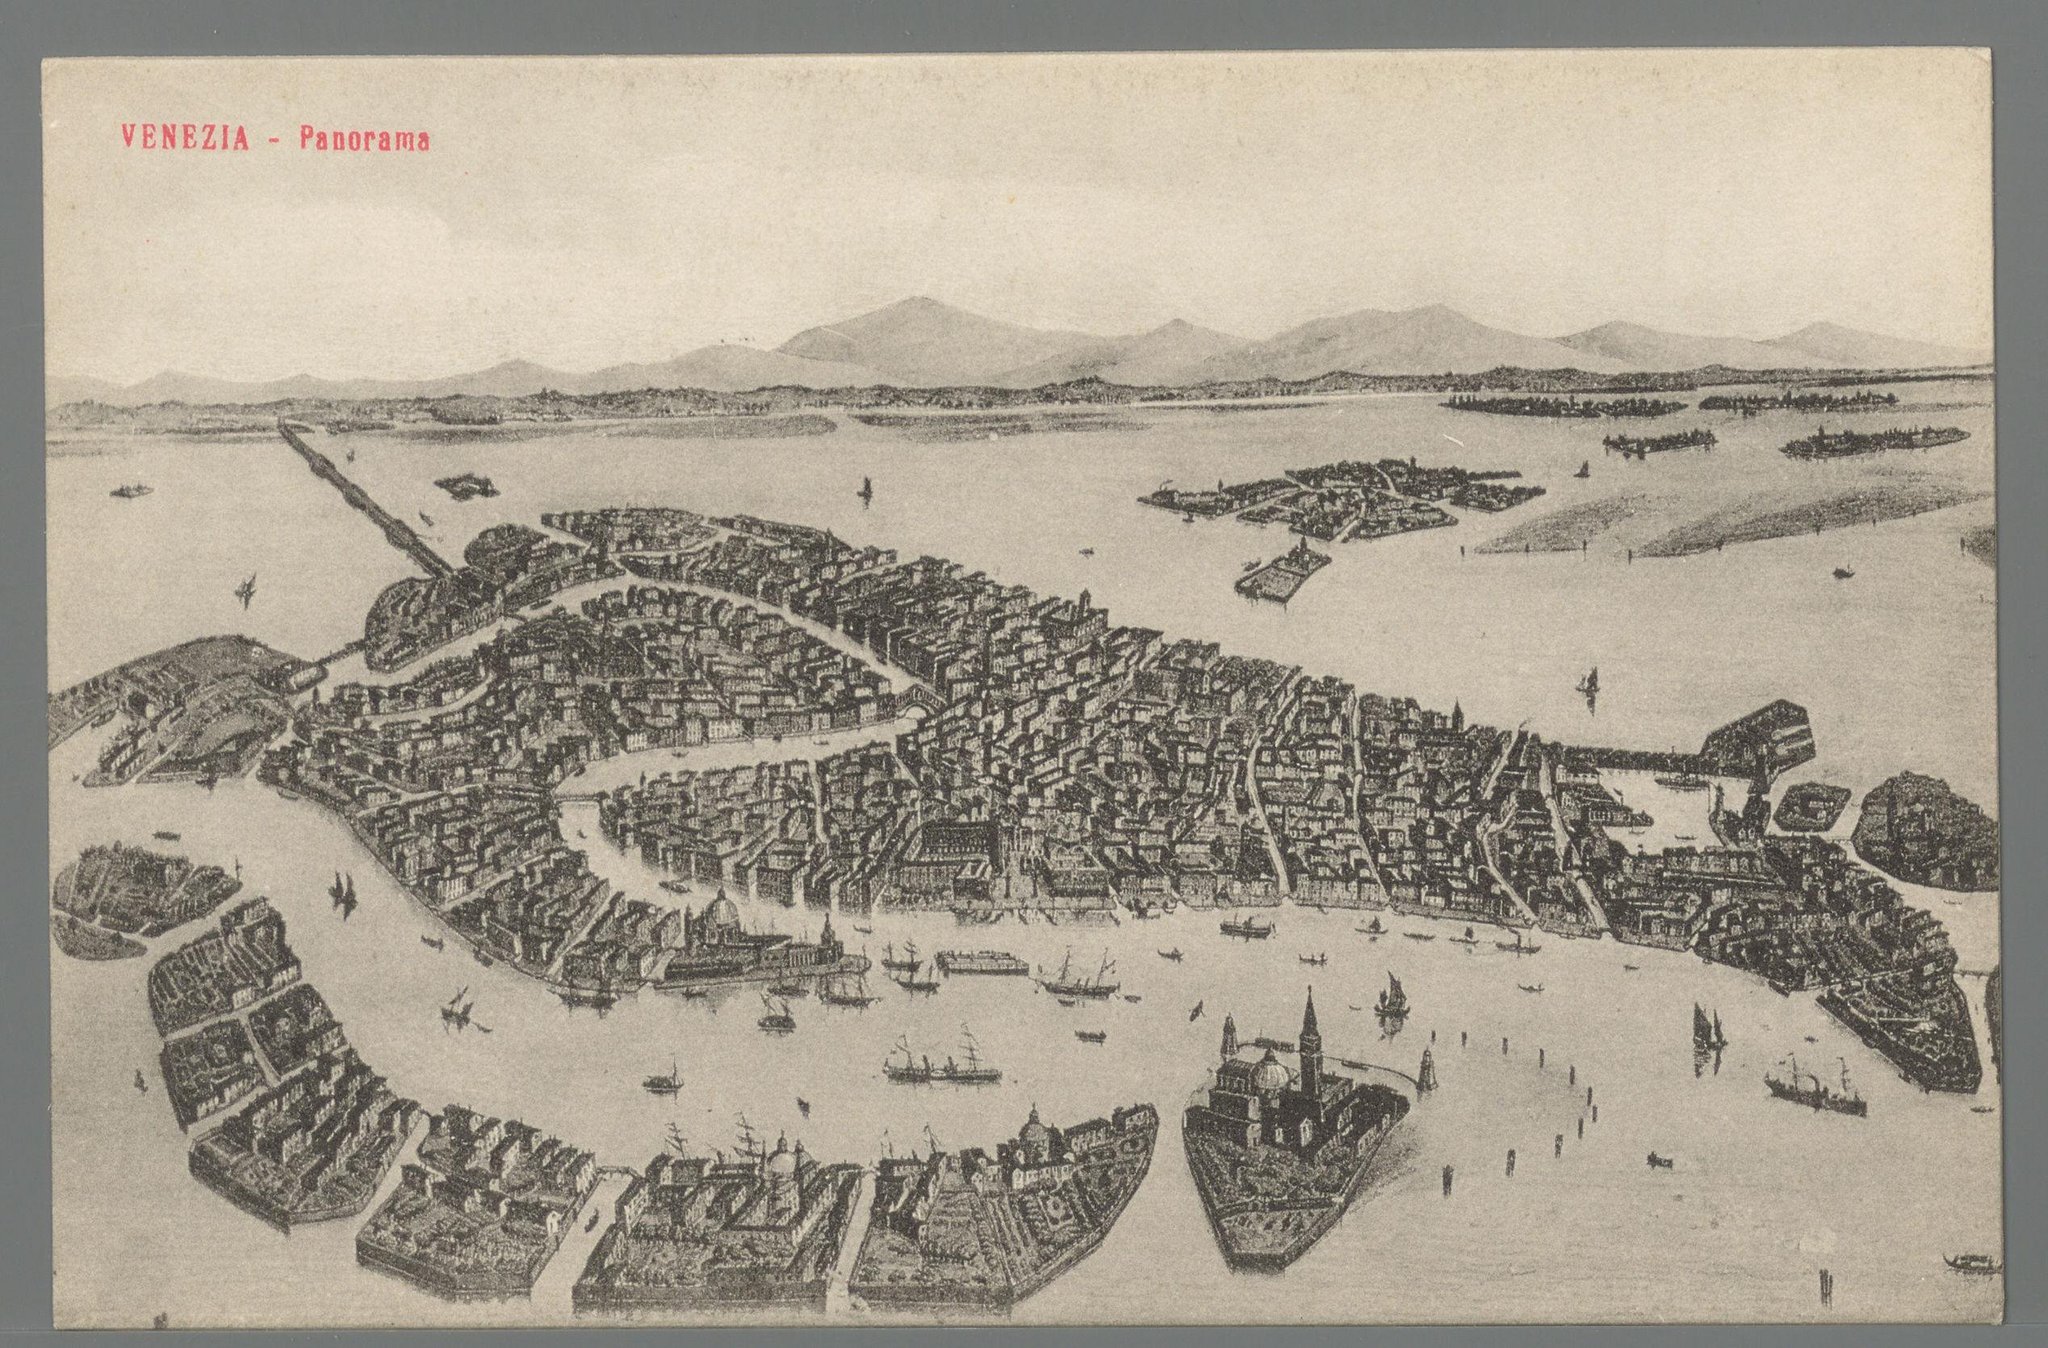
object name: reproduction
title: Venezia. Panorama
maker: Anonymous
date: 1906-1920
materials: cardboard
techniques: photograph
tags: prospect of village, silhouette of village, venice